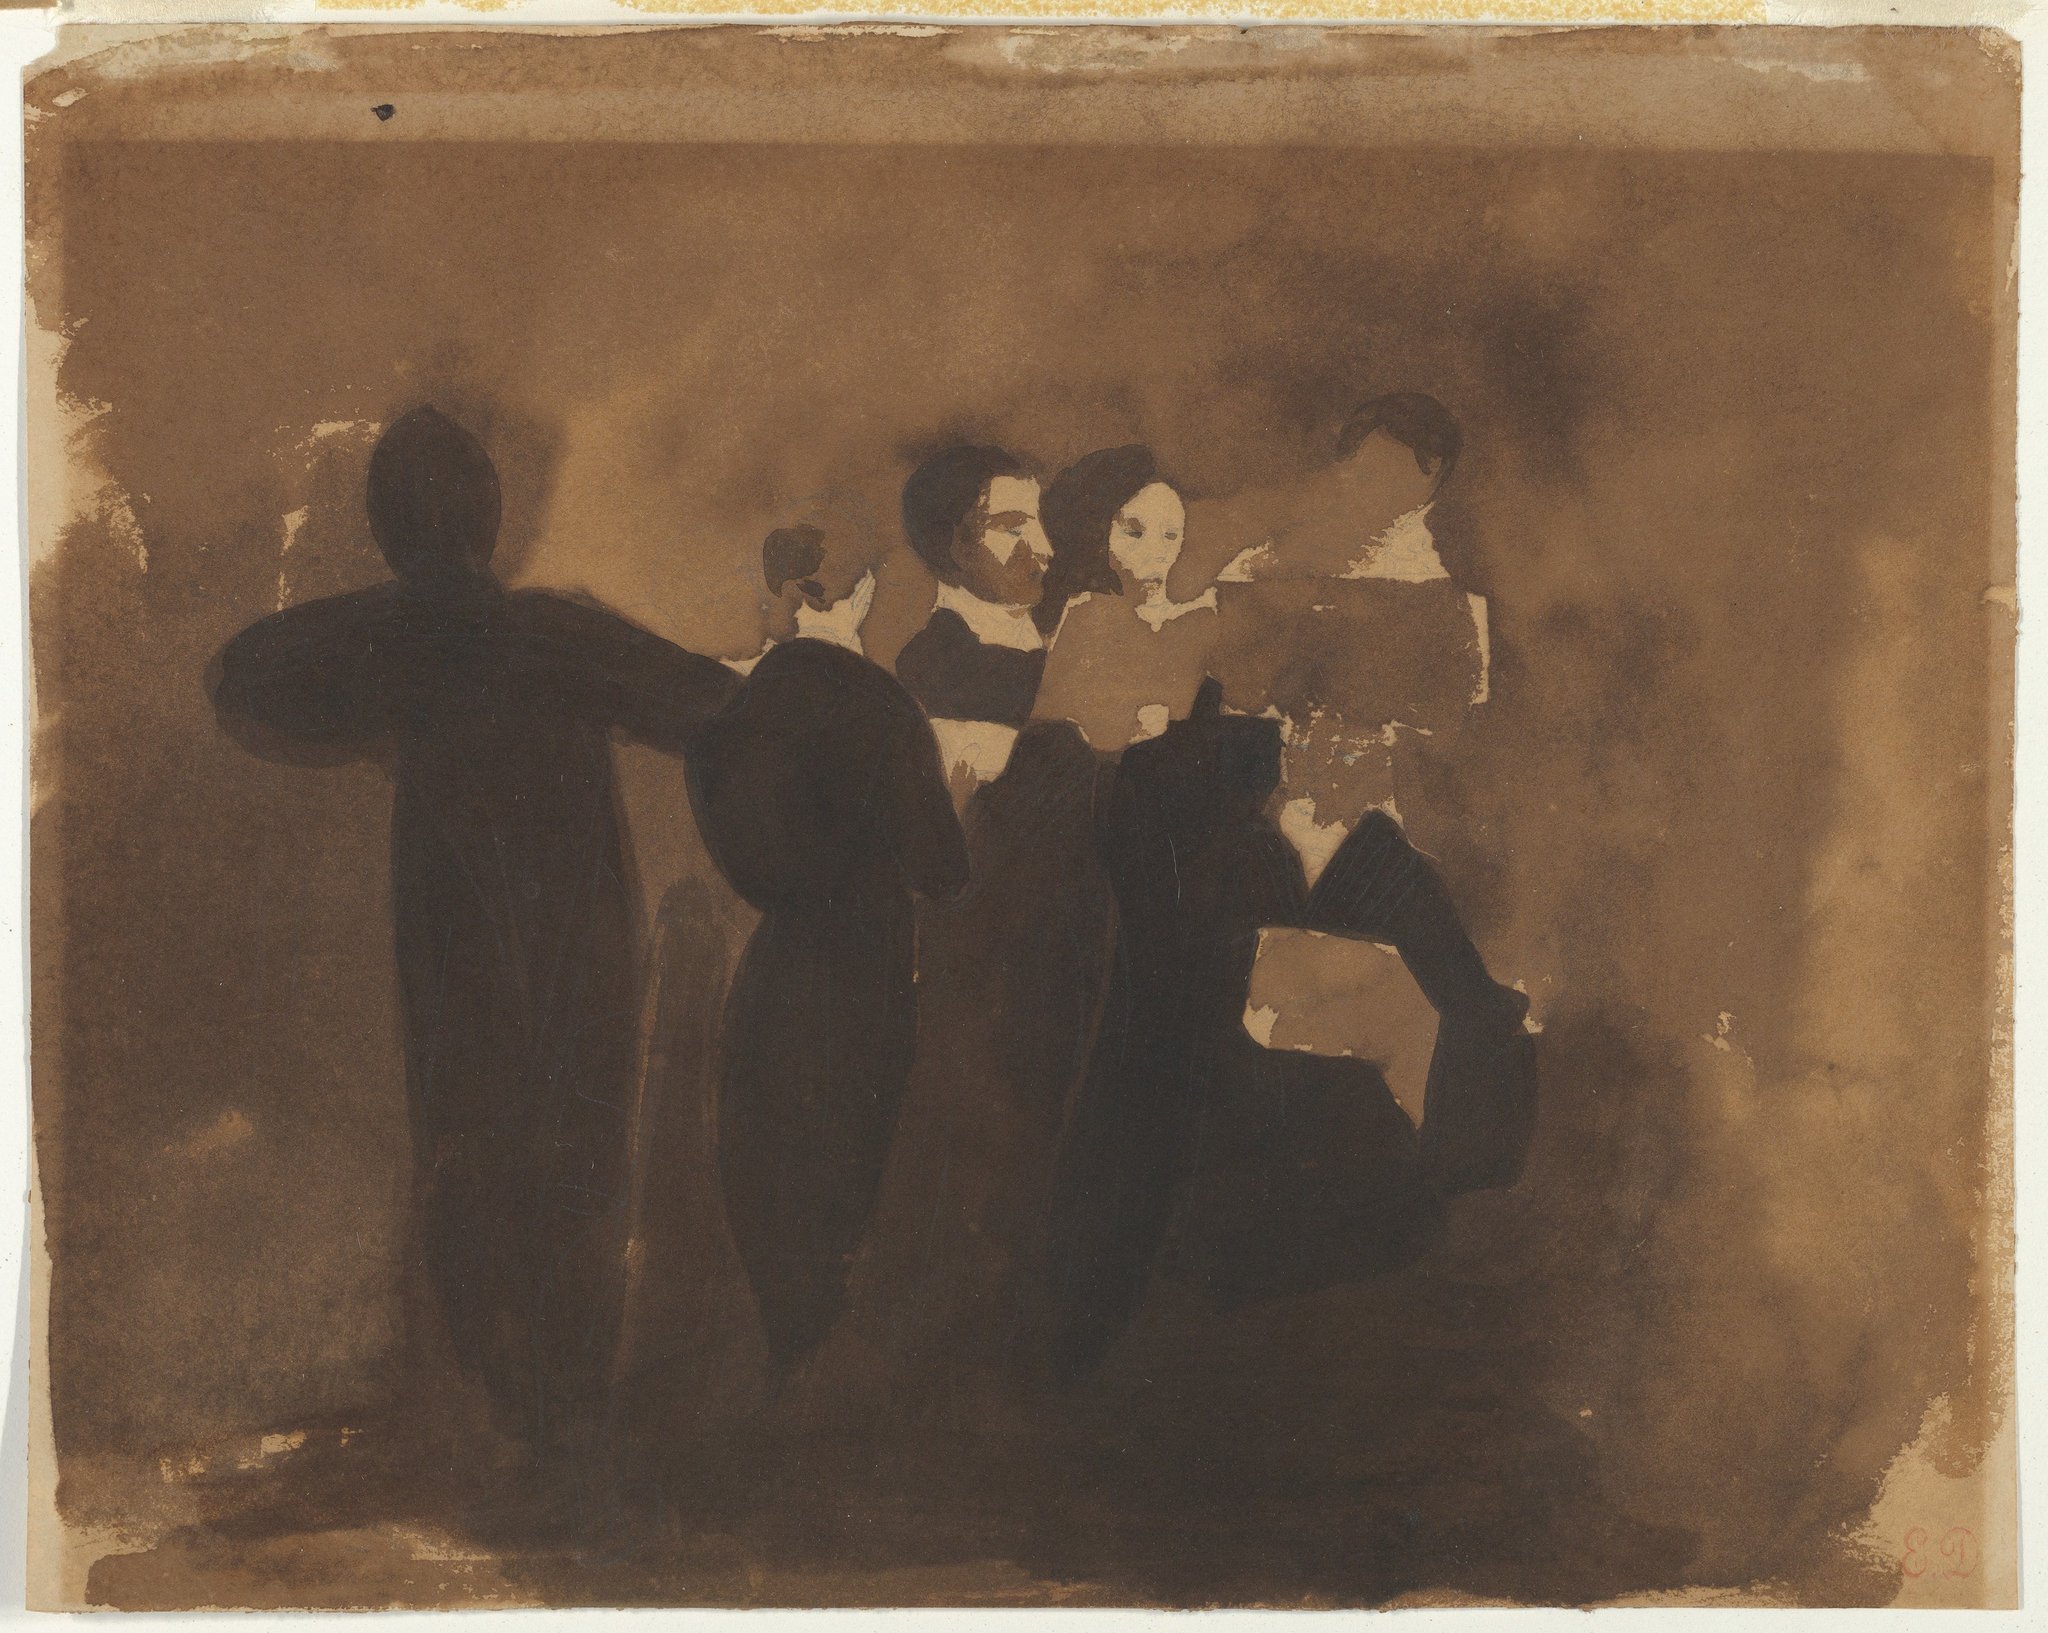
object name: drawing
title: A Choral Group of Five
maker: eugène delacroix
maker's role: artist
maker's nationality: french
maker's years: 1798-1863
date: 1840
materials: graphite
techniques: brush, wash